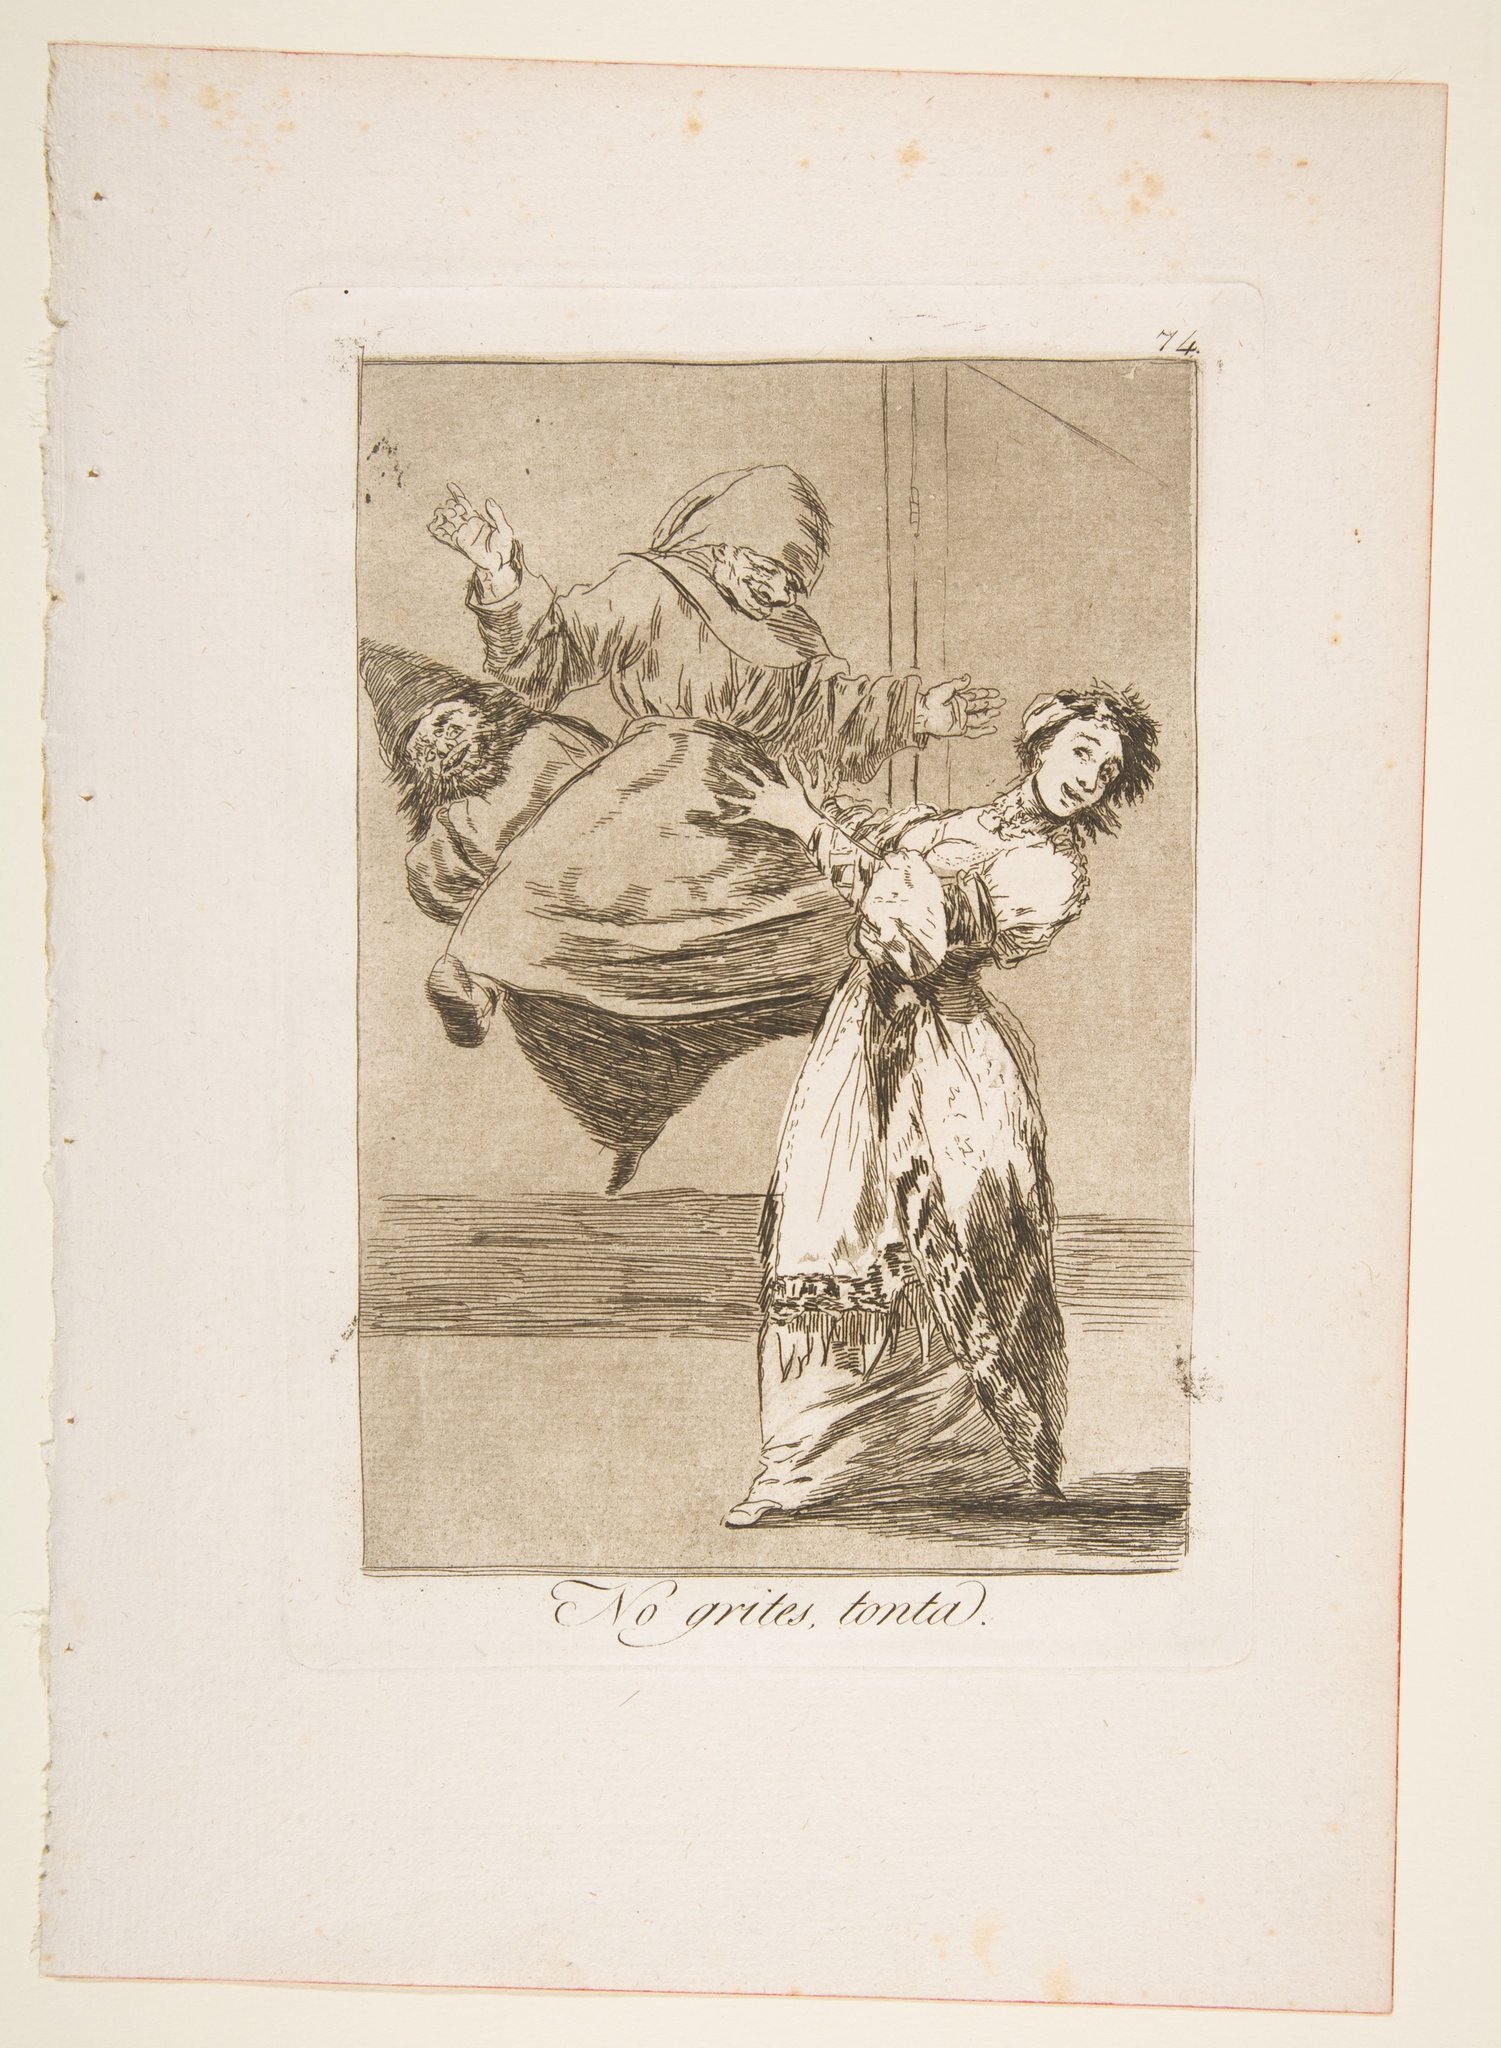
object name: print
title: Plate 74 from "Los Caprichos": Don't scream, stupid (No grites, tonta)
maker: goya (francisco de goya y lucientes)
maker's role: artist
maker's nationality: spanish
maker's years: 1746-1828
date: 1799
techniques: aquatint, burnishing, etching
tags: women